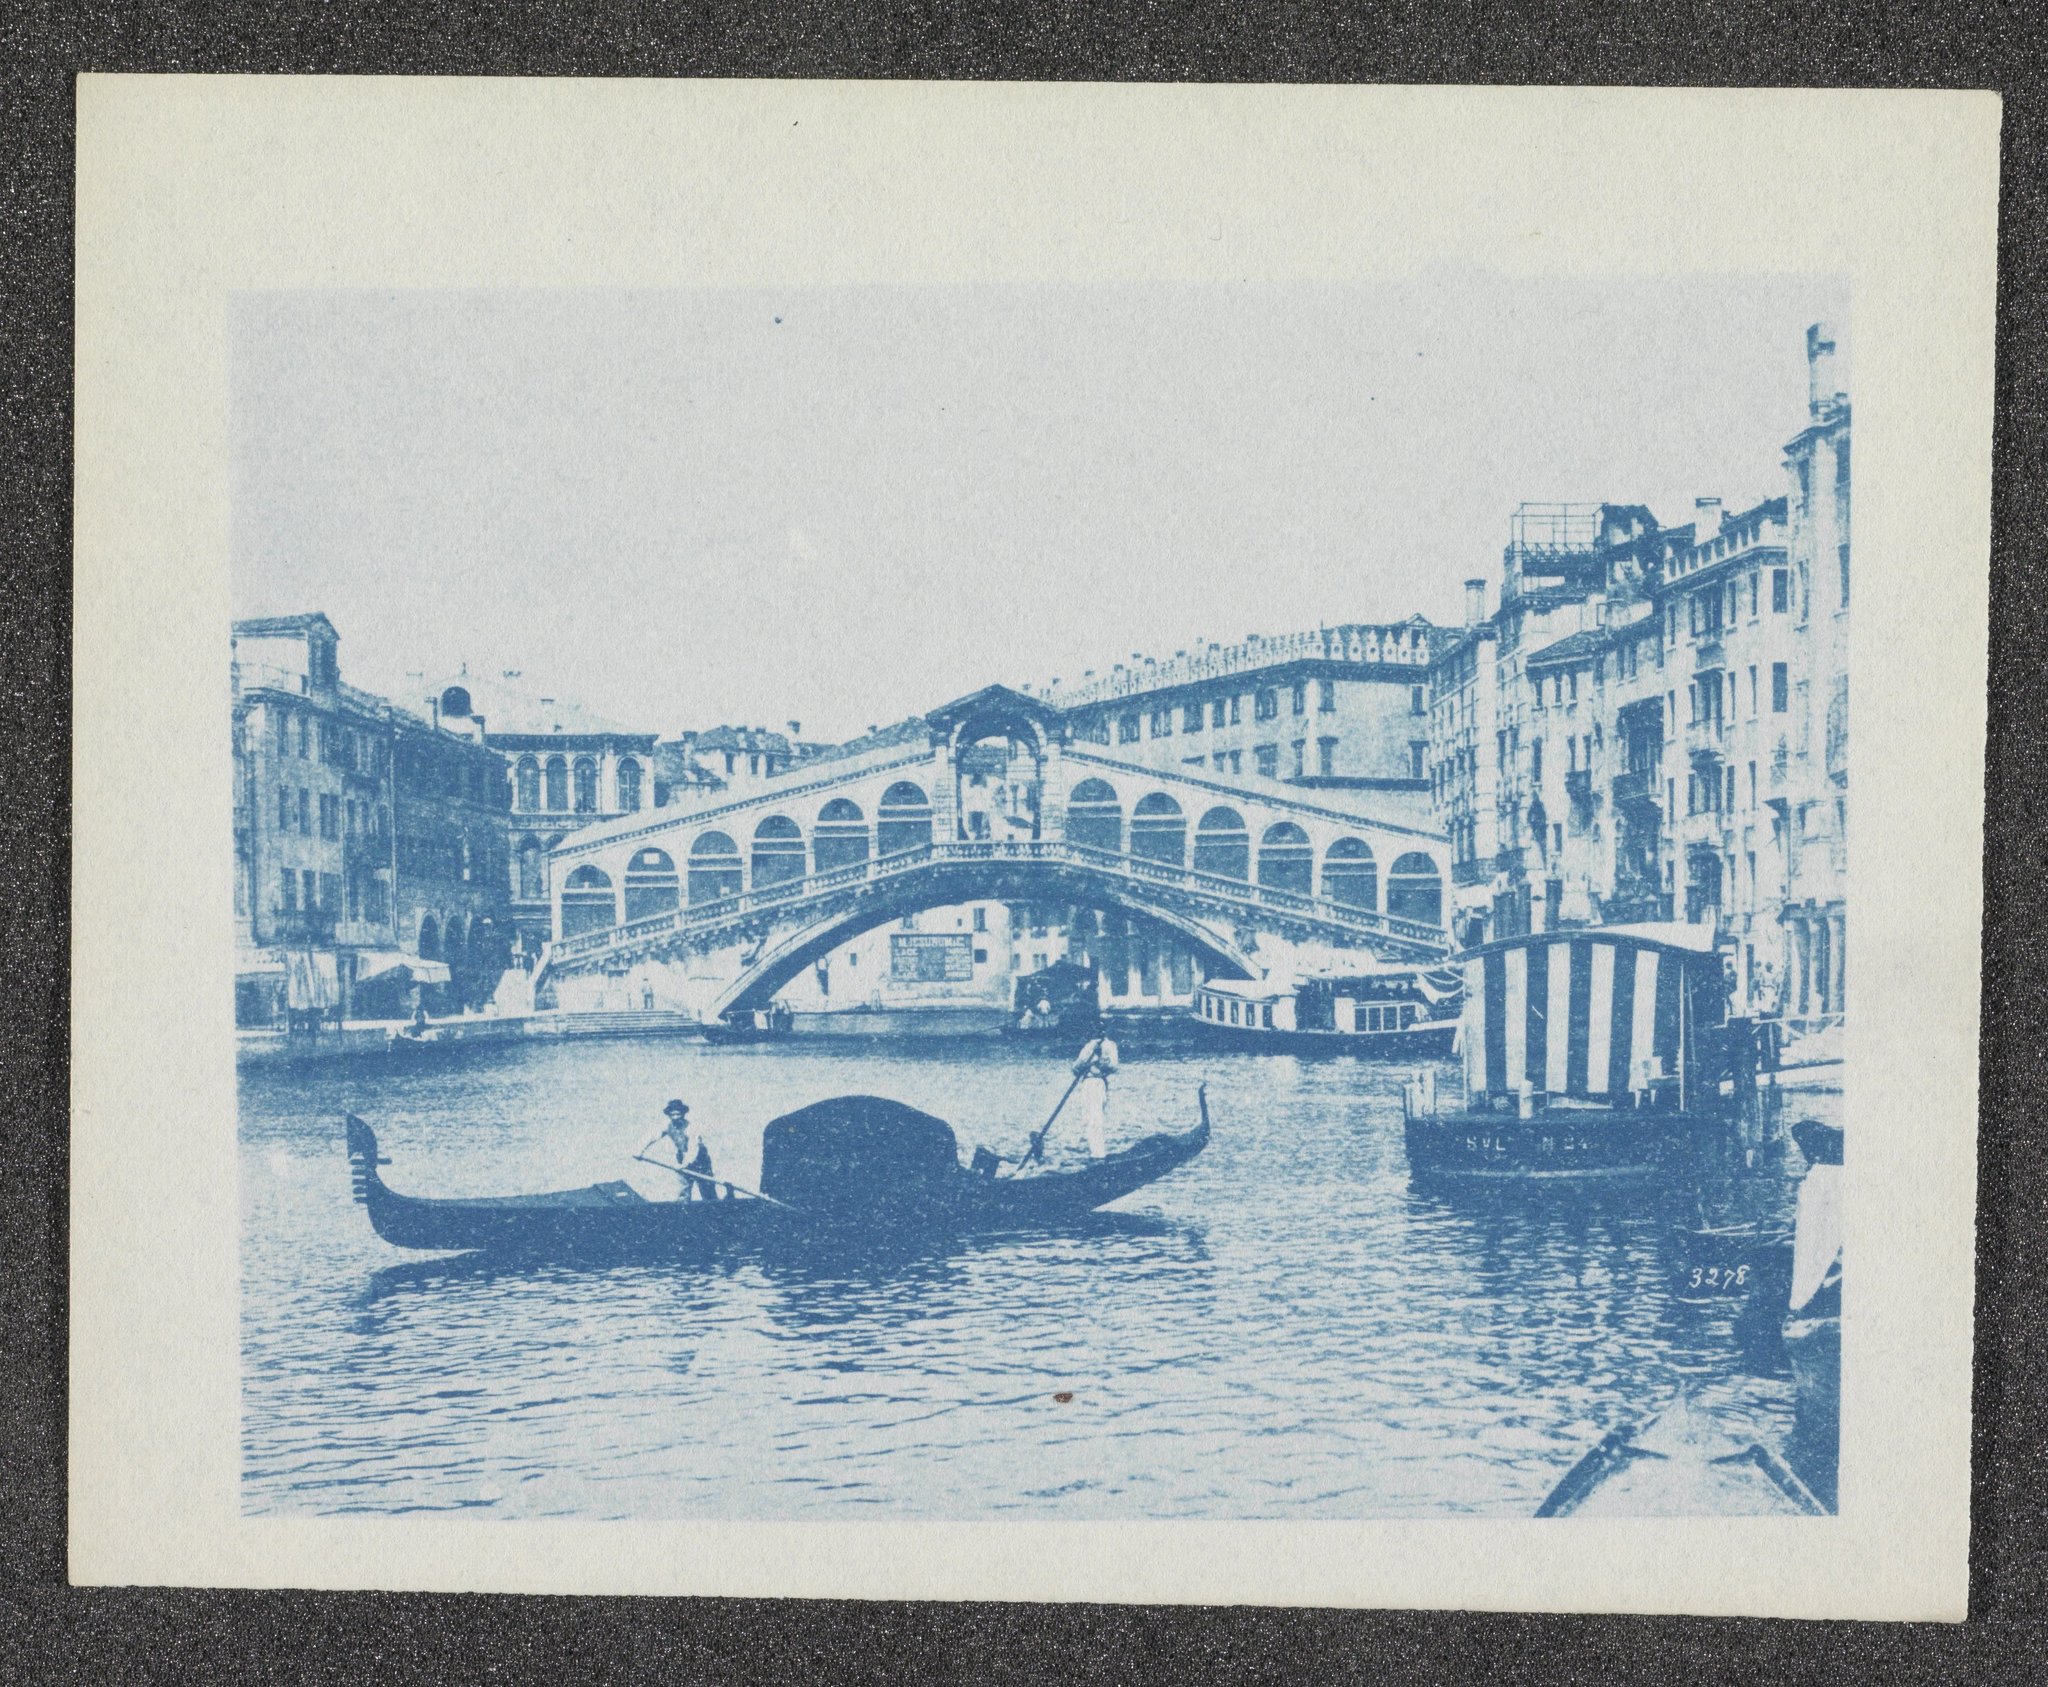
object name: photograph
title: Fotoreproductie van een foto van de Rialtobrug over het Canal Grande te Venetië, op de voorgrond een gondel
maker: Anonymous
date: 1890-1905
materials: paper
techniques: cyanotype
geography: venice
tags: bridge in city across river, canal, etc., gondola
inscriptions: inscription: ‘The Rialto - oldest bridge/ in Venice - Mentioned/ in Merchants of Venice/ by Shylock!/ "Many a time and oft on the Rialto"’, number: ‘3278’